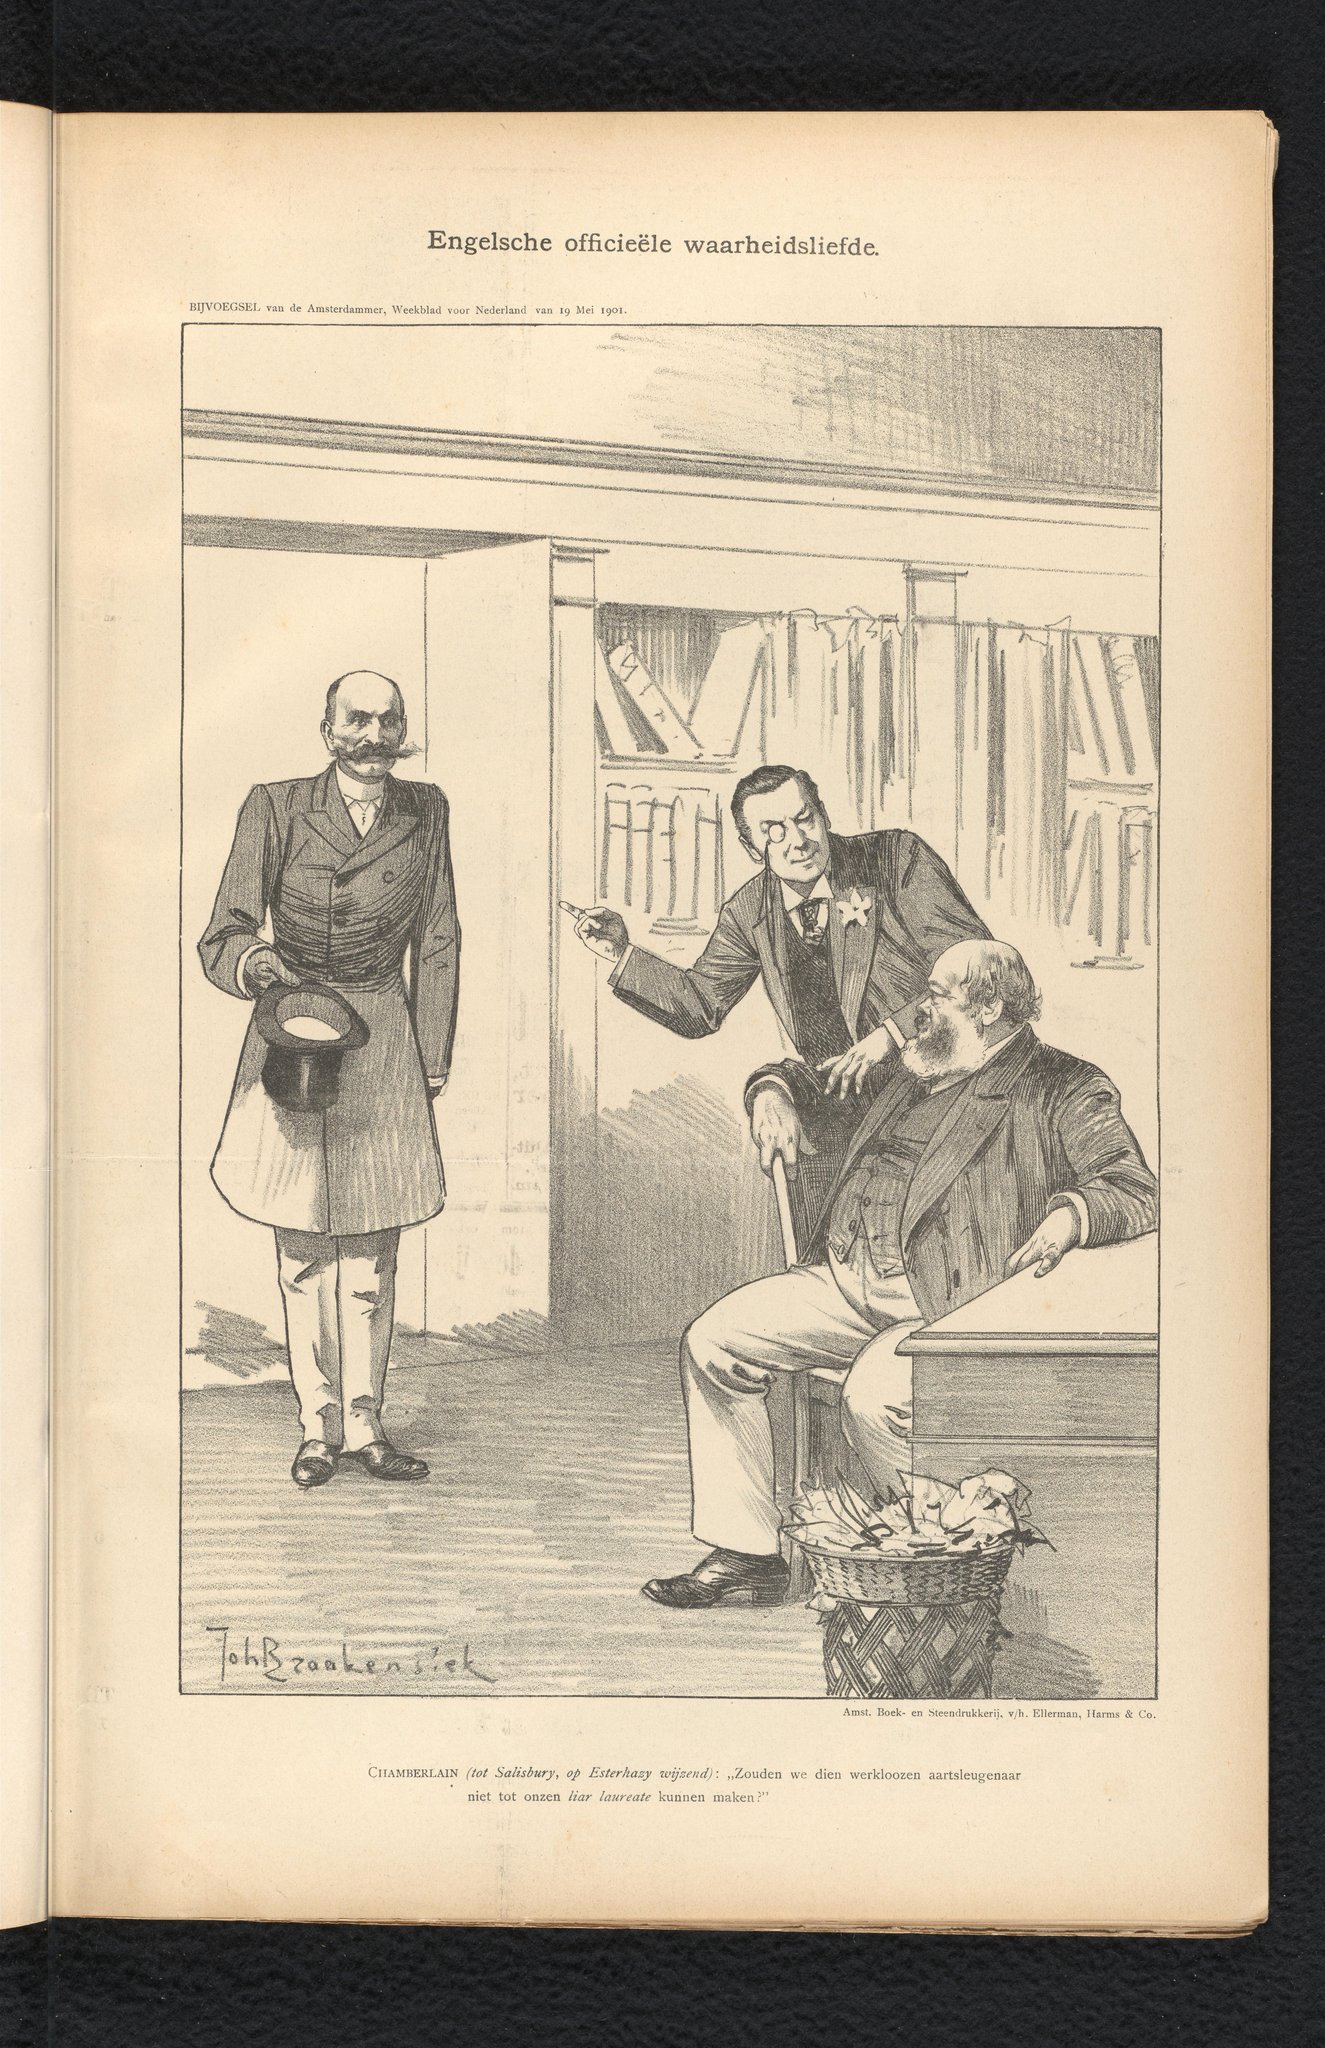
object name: cartoon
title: Engelsche officieële waarheidsliefde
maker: johan braakensiek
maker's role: draughtsman, print maker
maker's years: 1858-1940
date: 1901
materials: paper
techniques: lithograph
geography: amsterdam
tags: political caricatures and satires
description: Joseph Chamberlain stelt Lord Salisbury voor om Ferdinand Esterhazy, de Franse spion uit de Dreyfusaffaire, als officiële leugenaar aan te nemen.